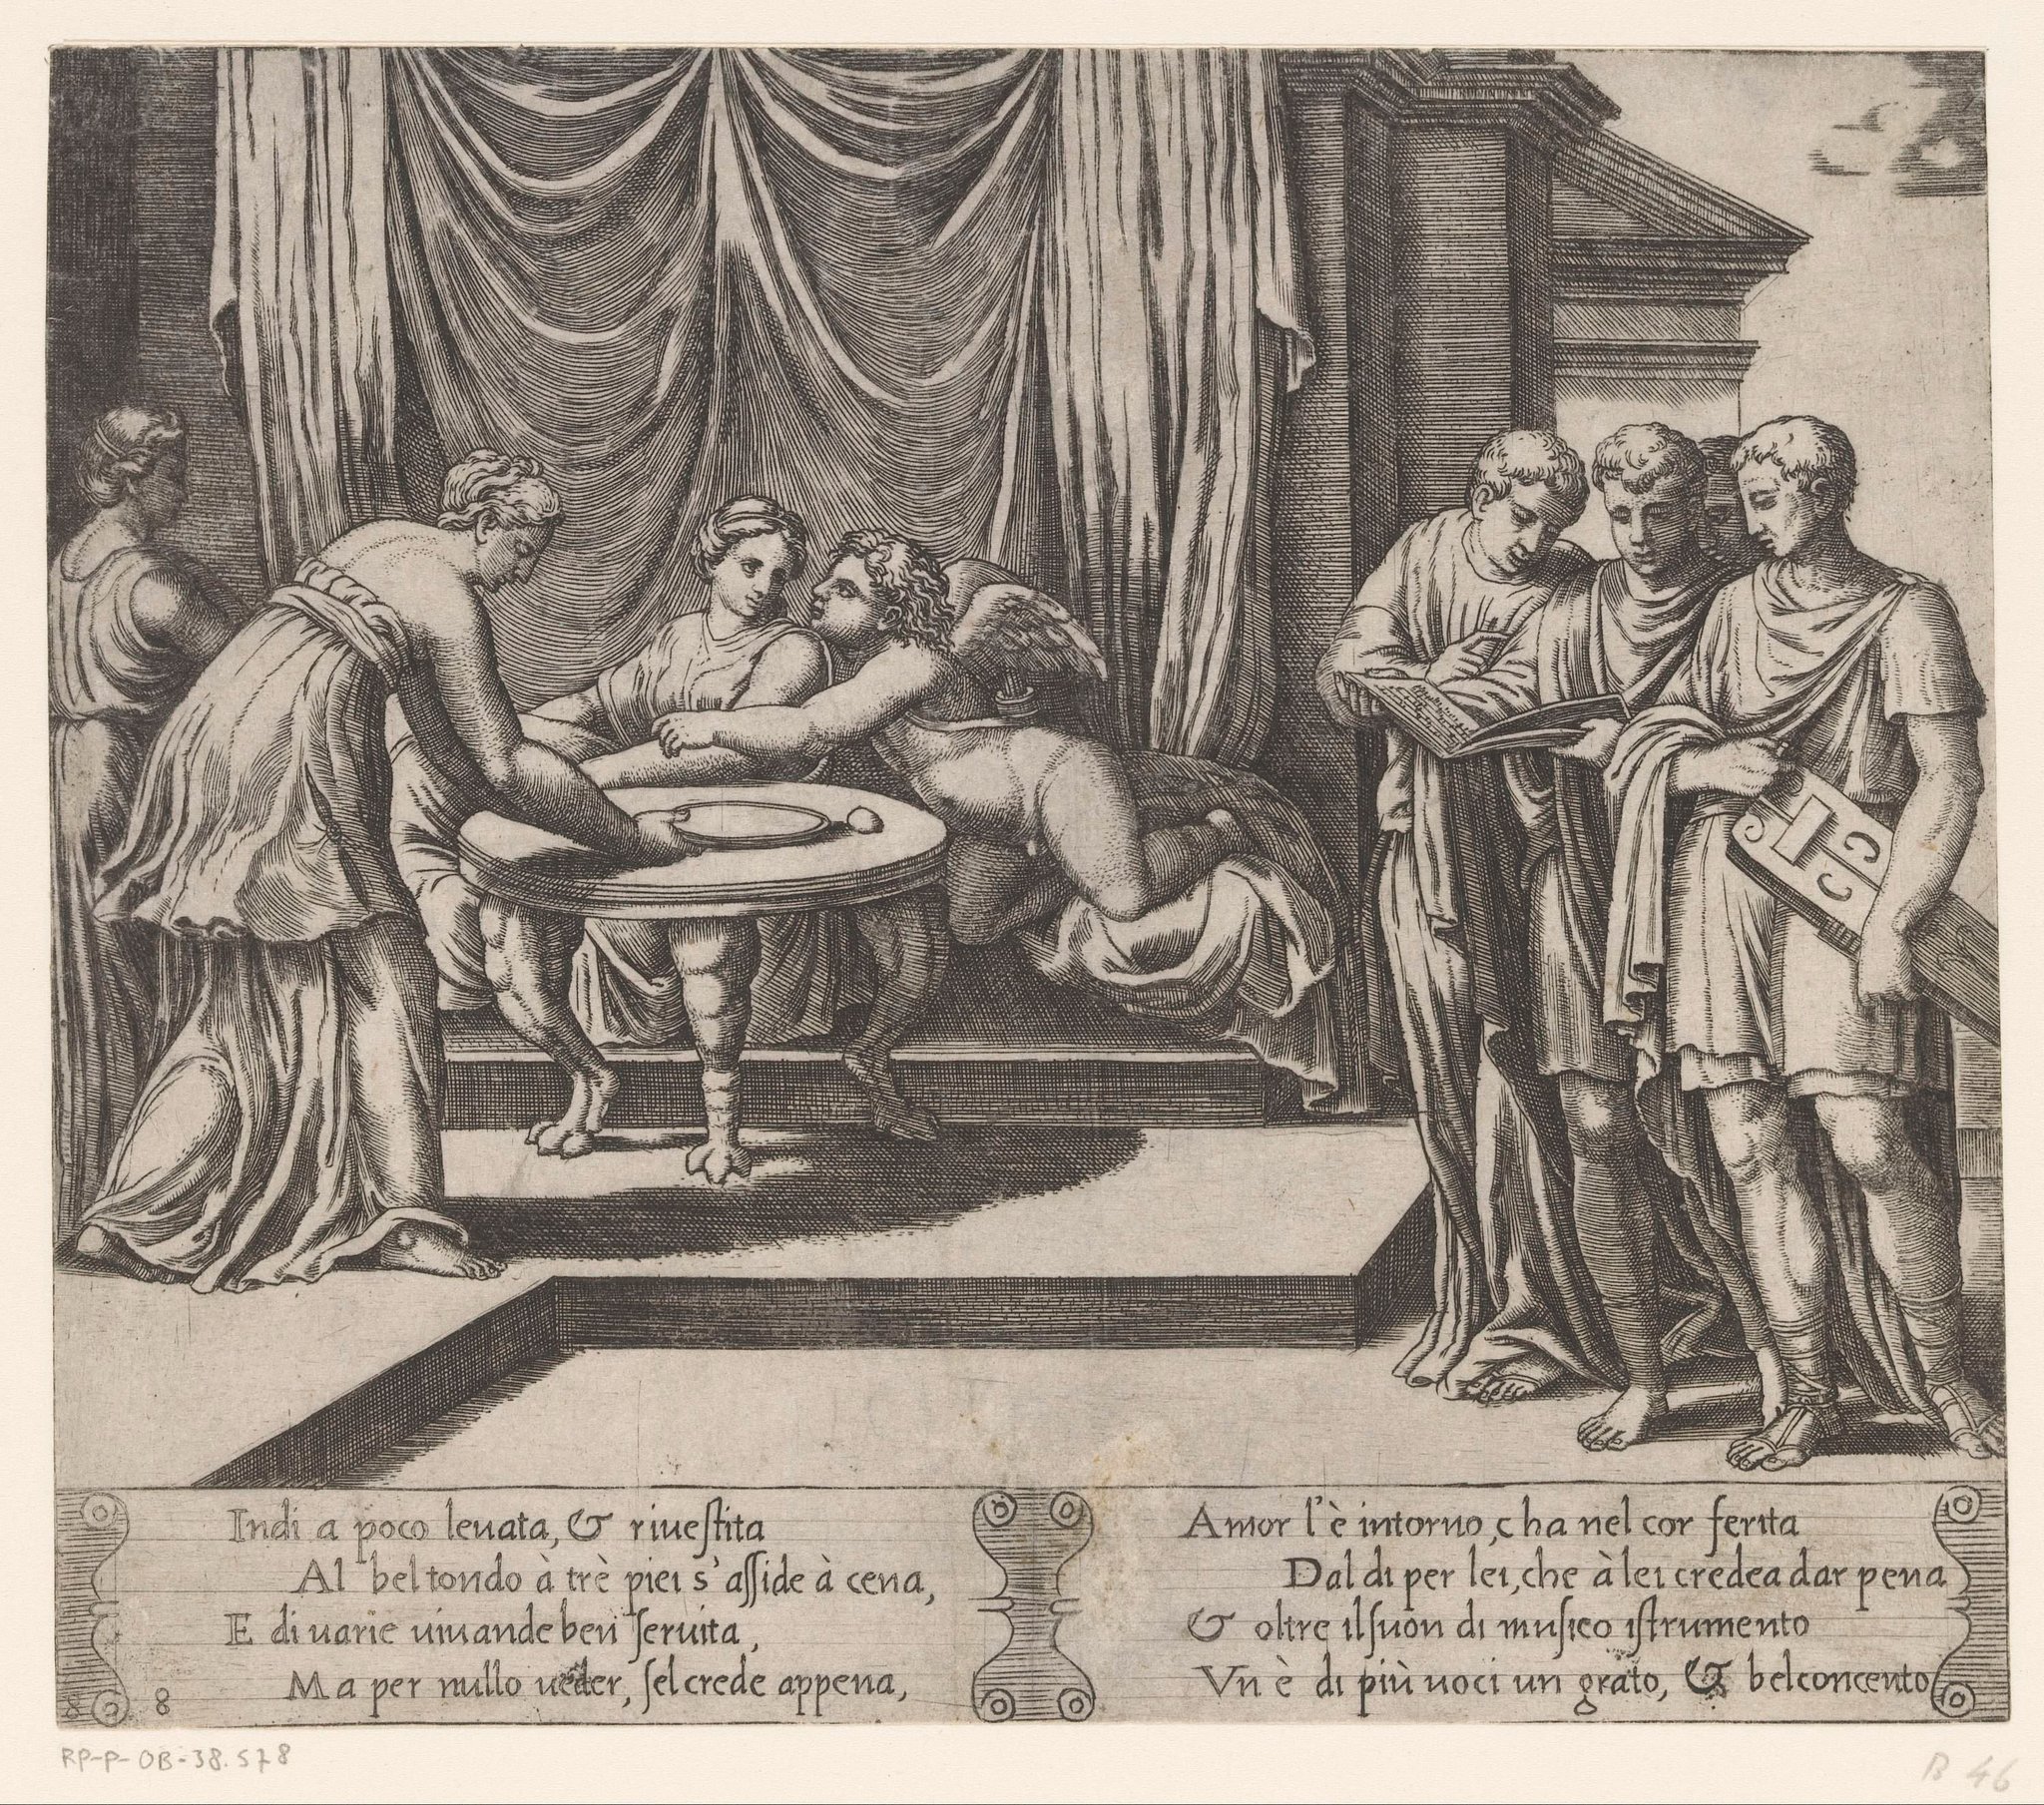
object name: print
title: Amor en Psyche op bed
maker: meester van de dobbelsteen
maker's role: print maker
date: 1530-1560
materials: paper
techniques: engraving, intaglio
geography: italy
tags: psyche is attended by invisible hands; the toilet of psyche, psyche in cupid's palace, hurdy-gurdy, vocal music, singing, cupid and psyche as lovers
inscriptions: collector's mark: Lugt 2228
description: Amor en Psyche op bed in het paleis van Amor. Rechts vier muzikanten met een liedboek en een draailier. Italiaanse tekst in twee cartouches in ondermarge. Tweemaal genummerd linksonder: 8.